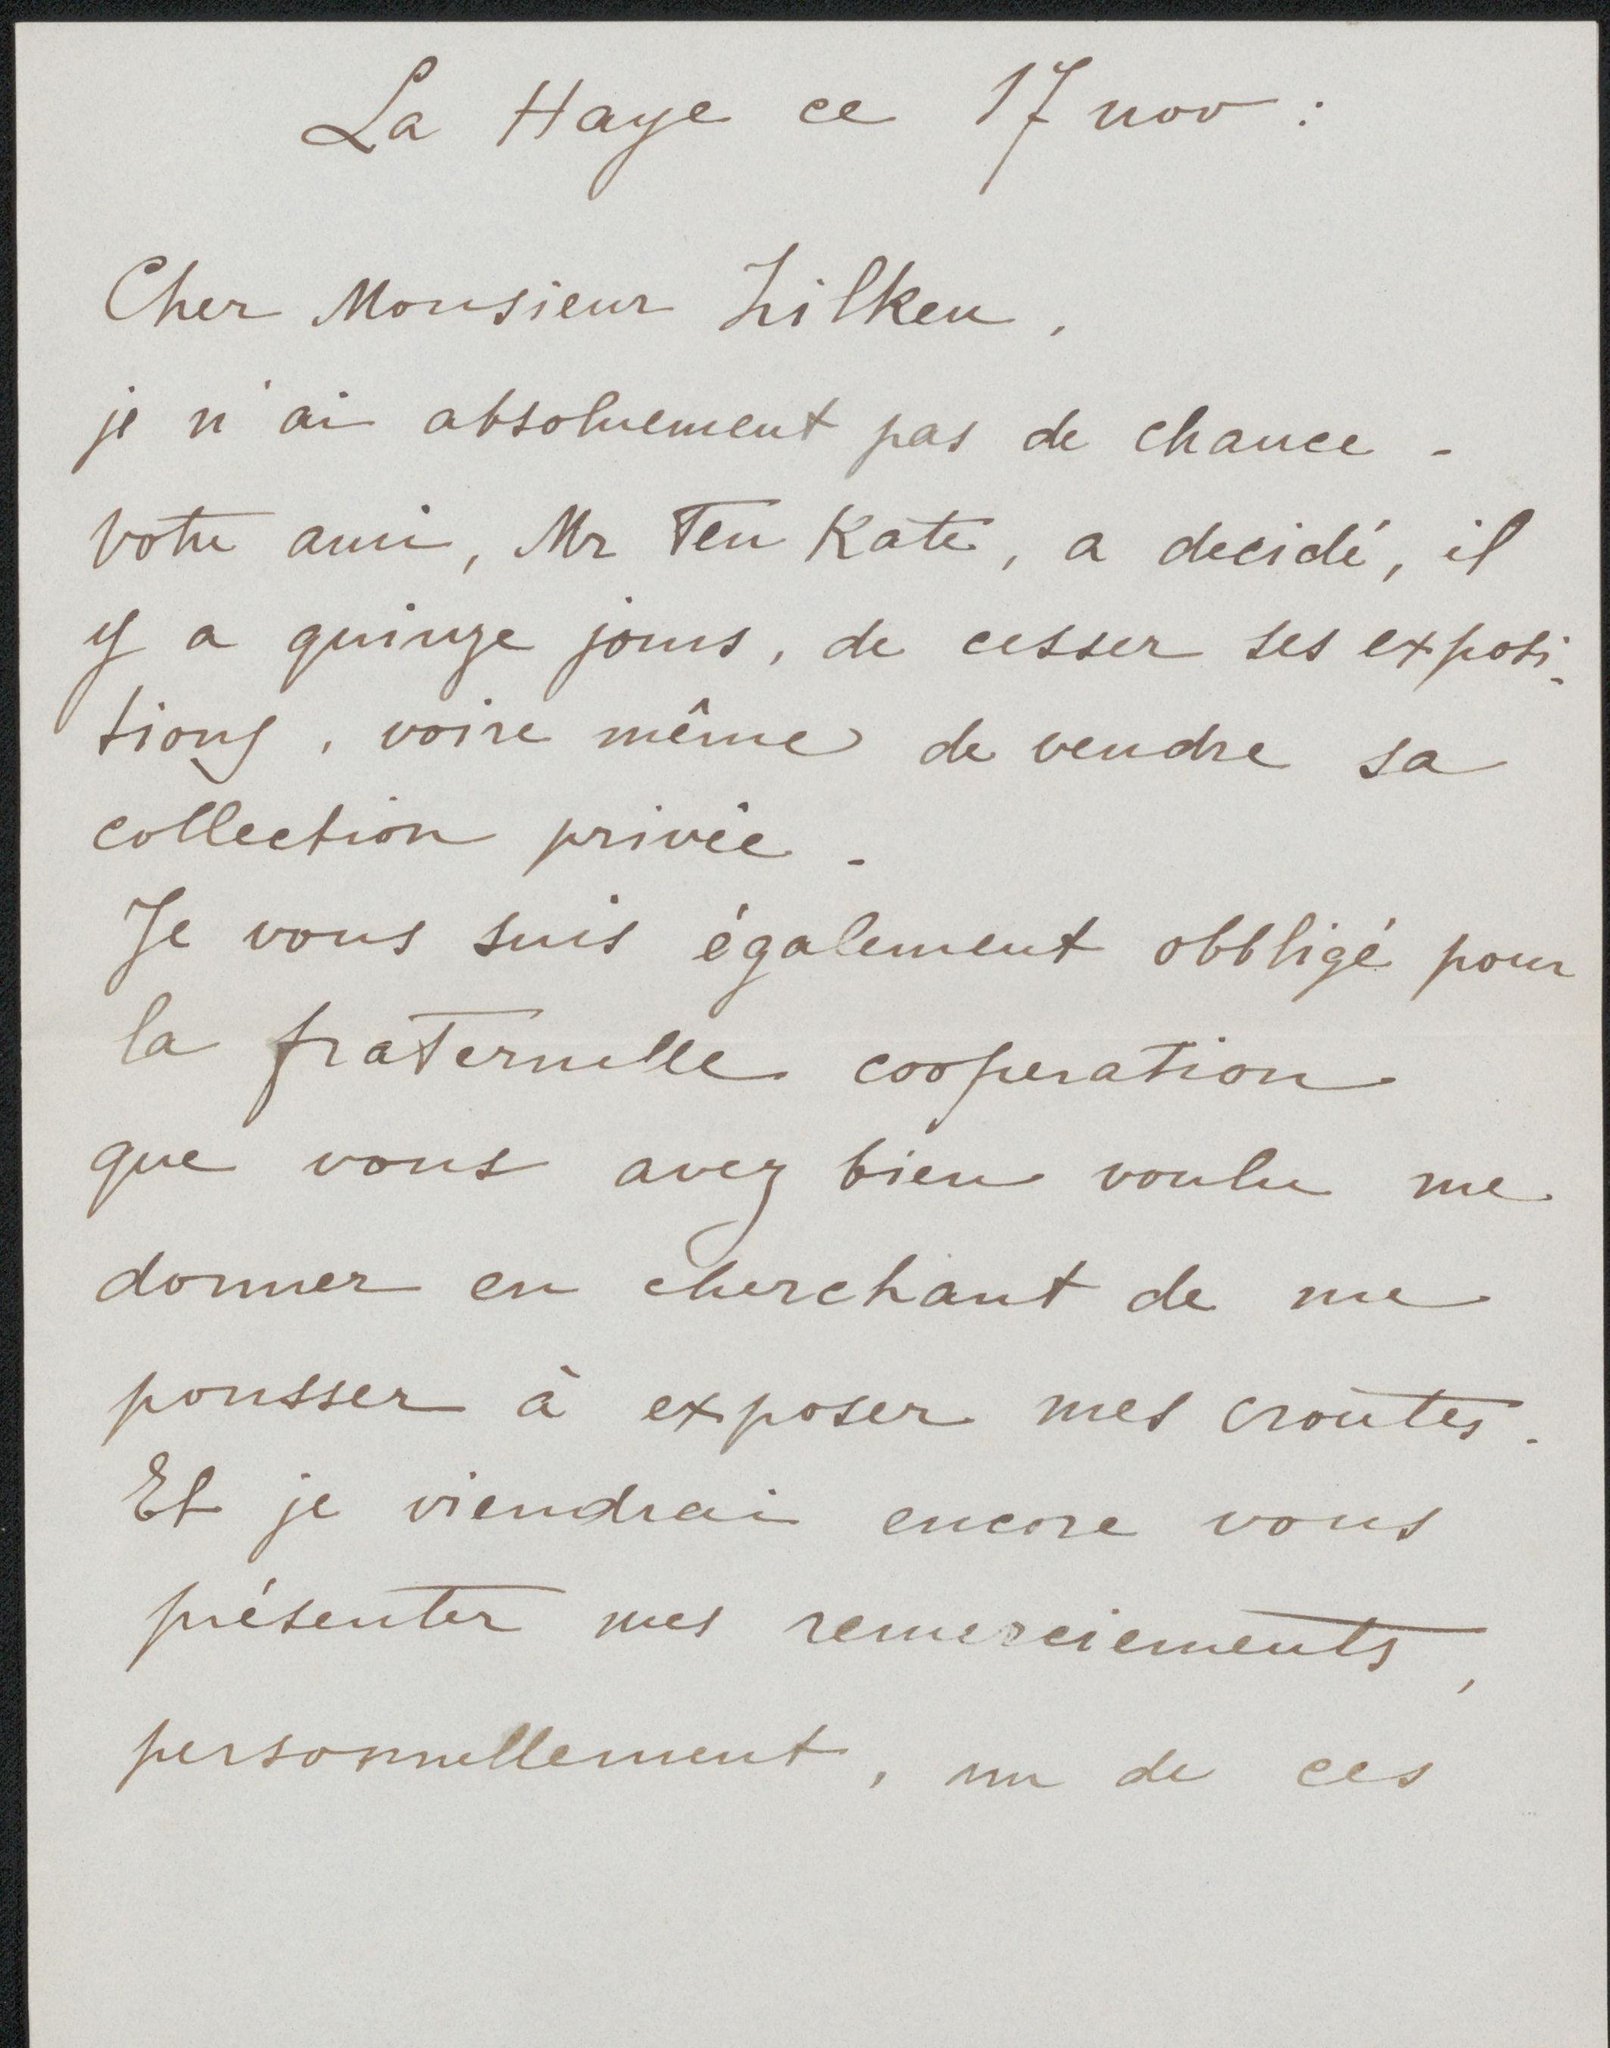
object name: letter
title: Brief aan Philip Zilcken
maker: carlo siviero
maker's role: painter, sculptor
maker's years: 1882-1953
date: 1911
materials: ink, paper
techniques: pen, writing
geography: the hague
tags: painter, draughtsman, philip zilcken, painting (including book-illumination, miniature-painting), exhibition ~ art, art collecting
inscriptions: collector's mark: ‘RPK’